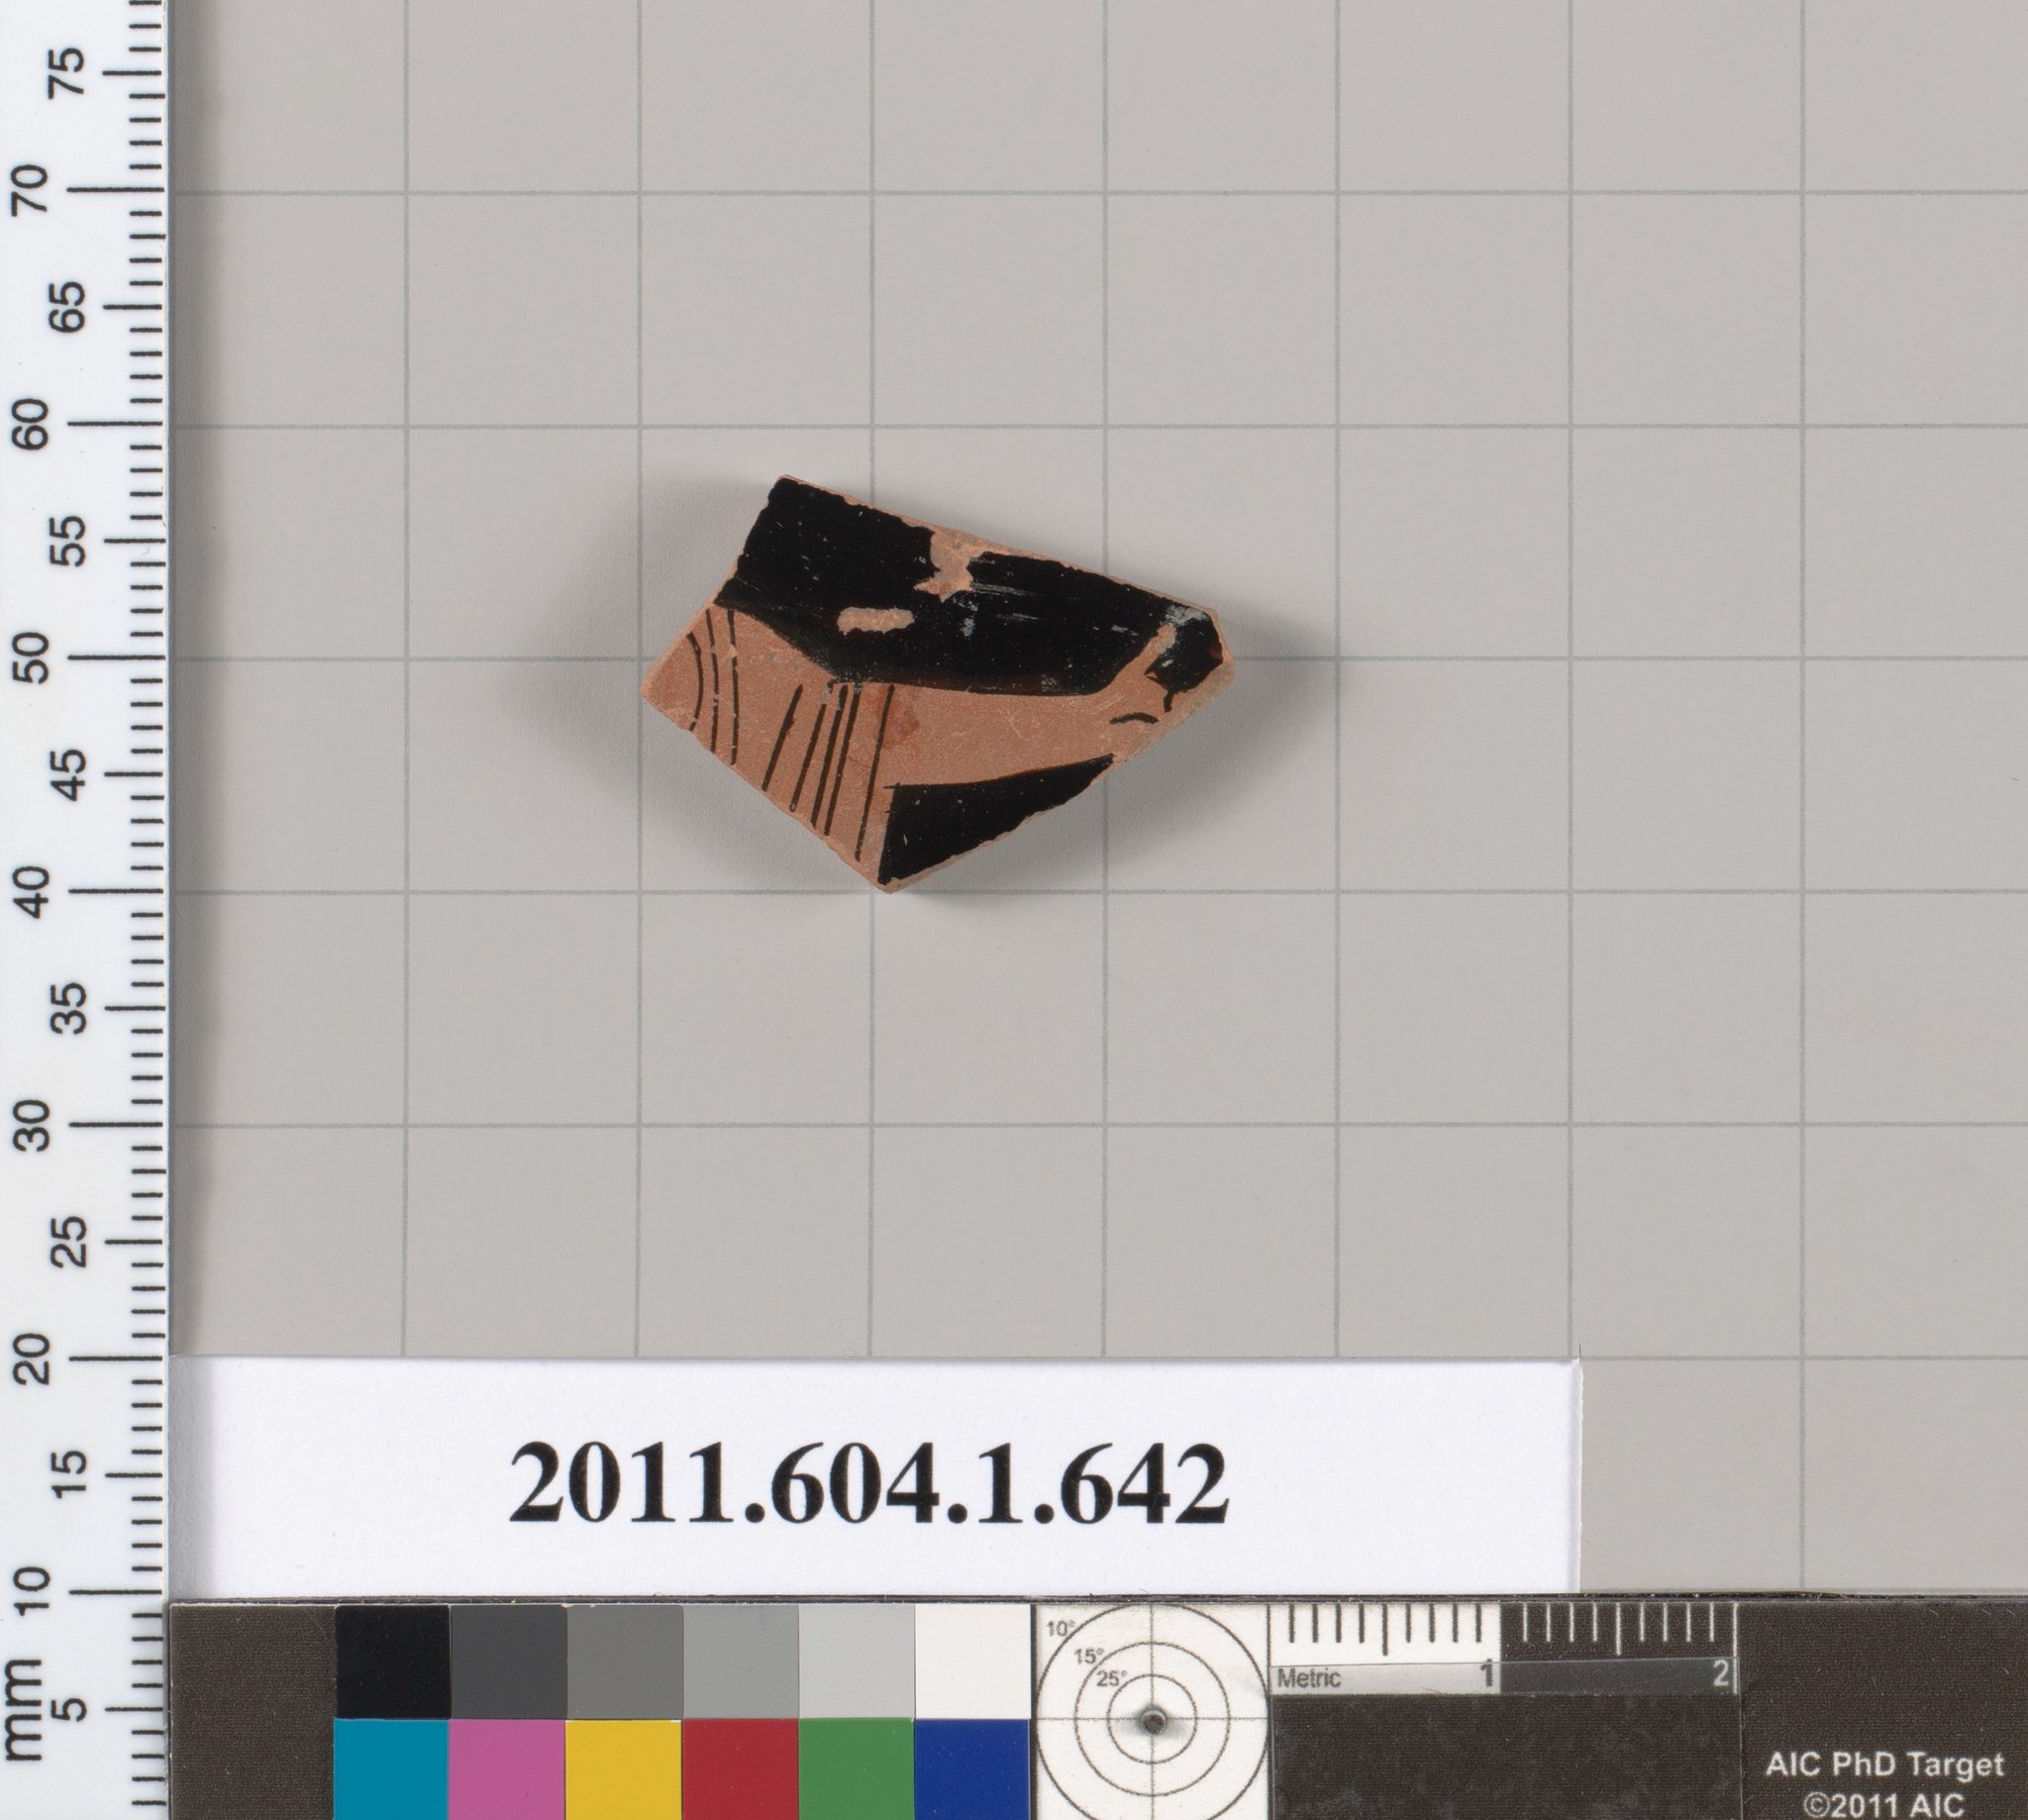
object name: kylix fragment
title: Terracotta fragment of a kylix (drinking cup)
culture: greek, attic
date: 475-451 BCE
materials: terracotta